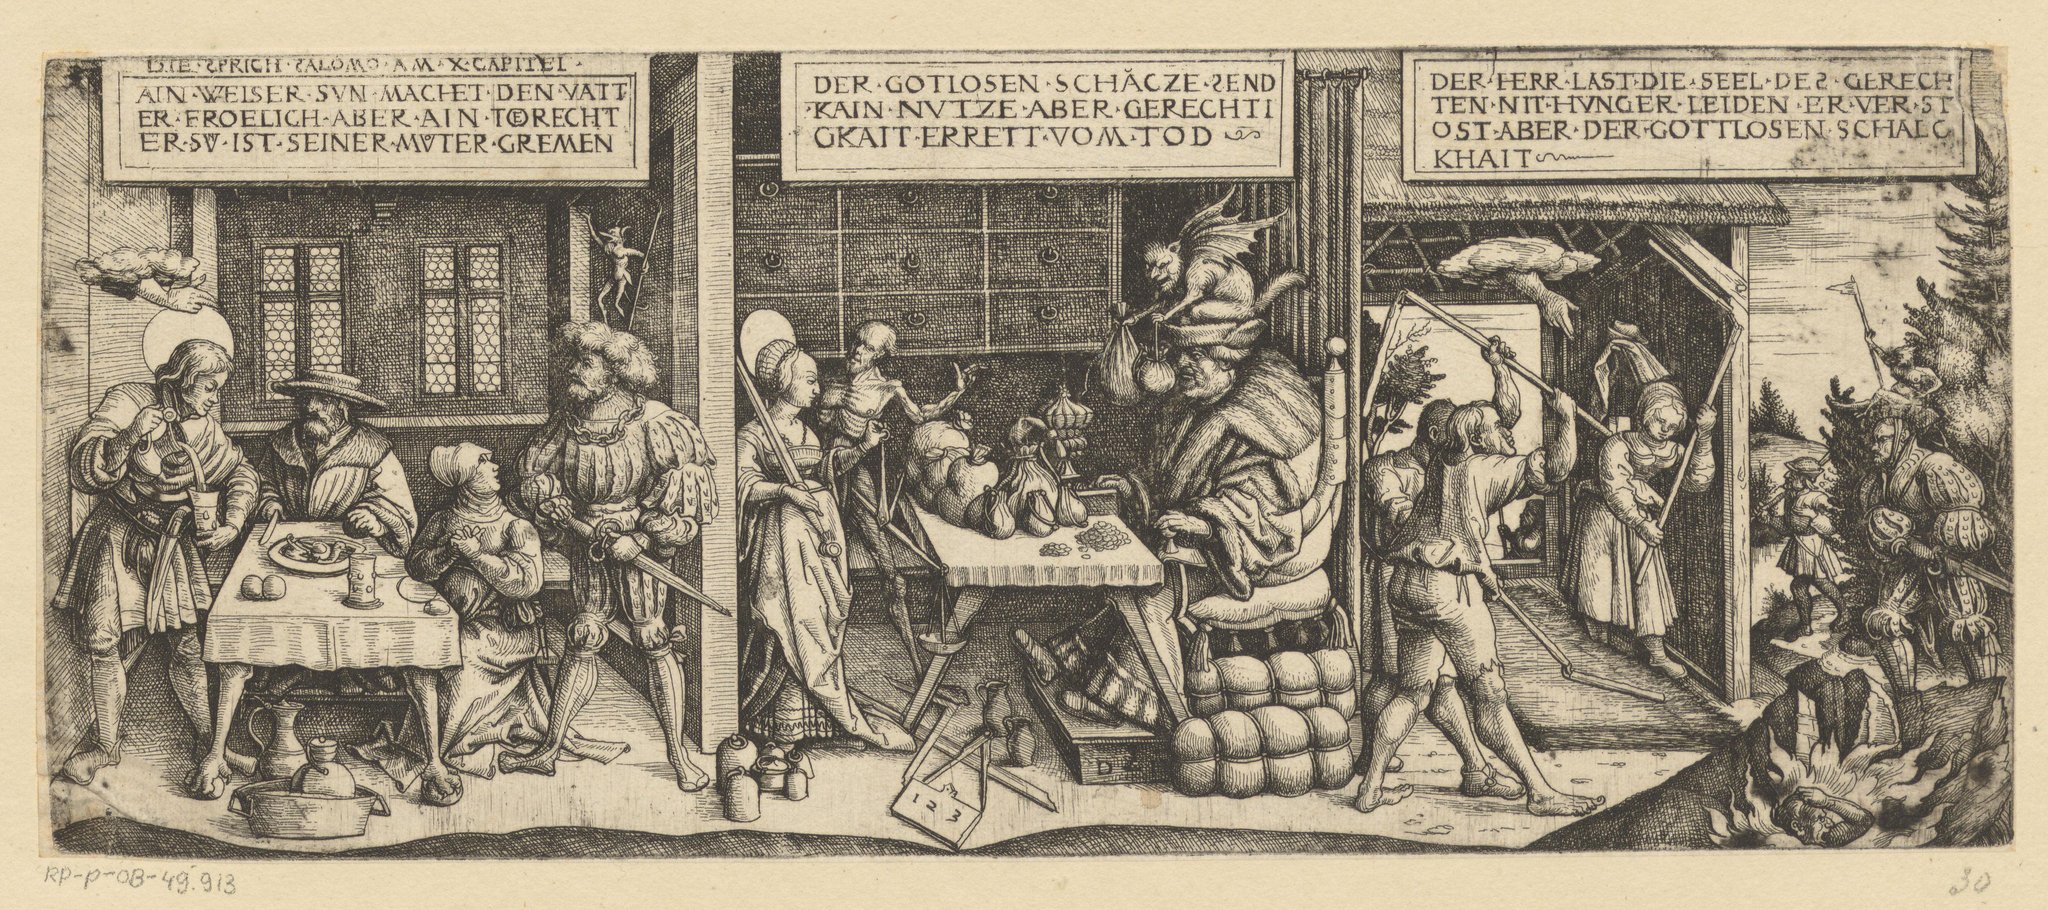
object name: print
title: Met wijsheid komt gerechtigheid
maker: daniel hopfer (i)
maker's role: print maker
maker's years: 1470-1536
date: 1504-1536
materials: paper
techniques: etching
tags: the book of proverbs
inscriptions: collector's mark: Lugt 240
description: Drie kaders met tekst in het Duits boven de voorstellingen met spreuken uit hoofdstuk 10 van Wijsheid van Salomo. Drie situaties verbeelden de consequenties van slechte keuzes, waarbij wijsheid deugdelijk wordt geacht. Nummer 123 centraal onderin.